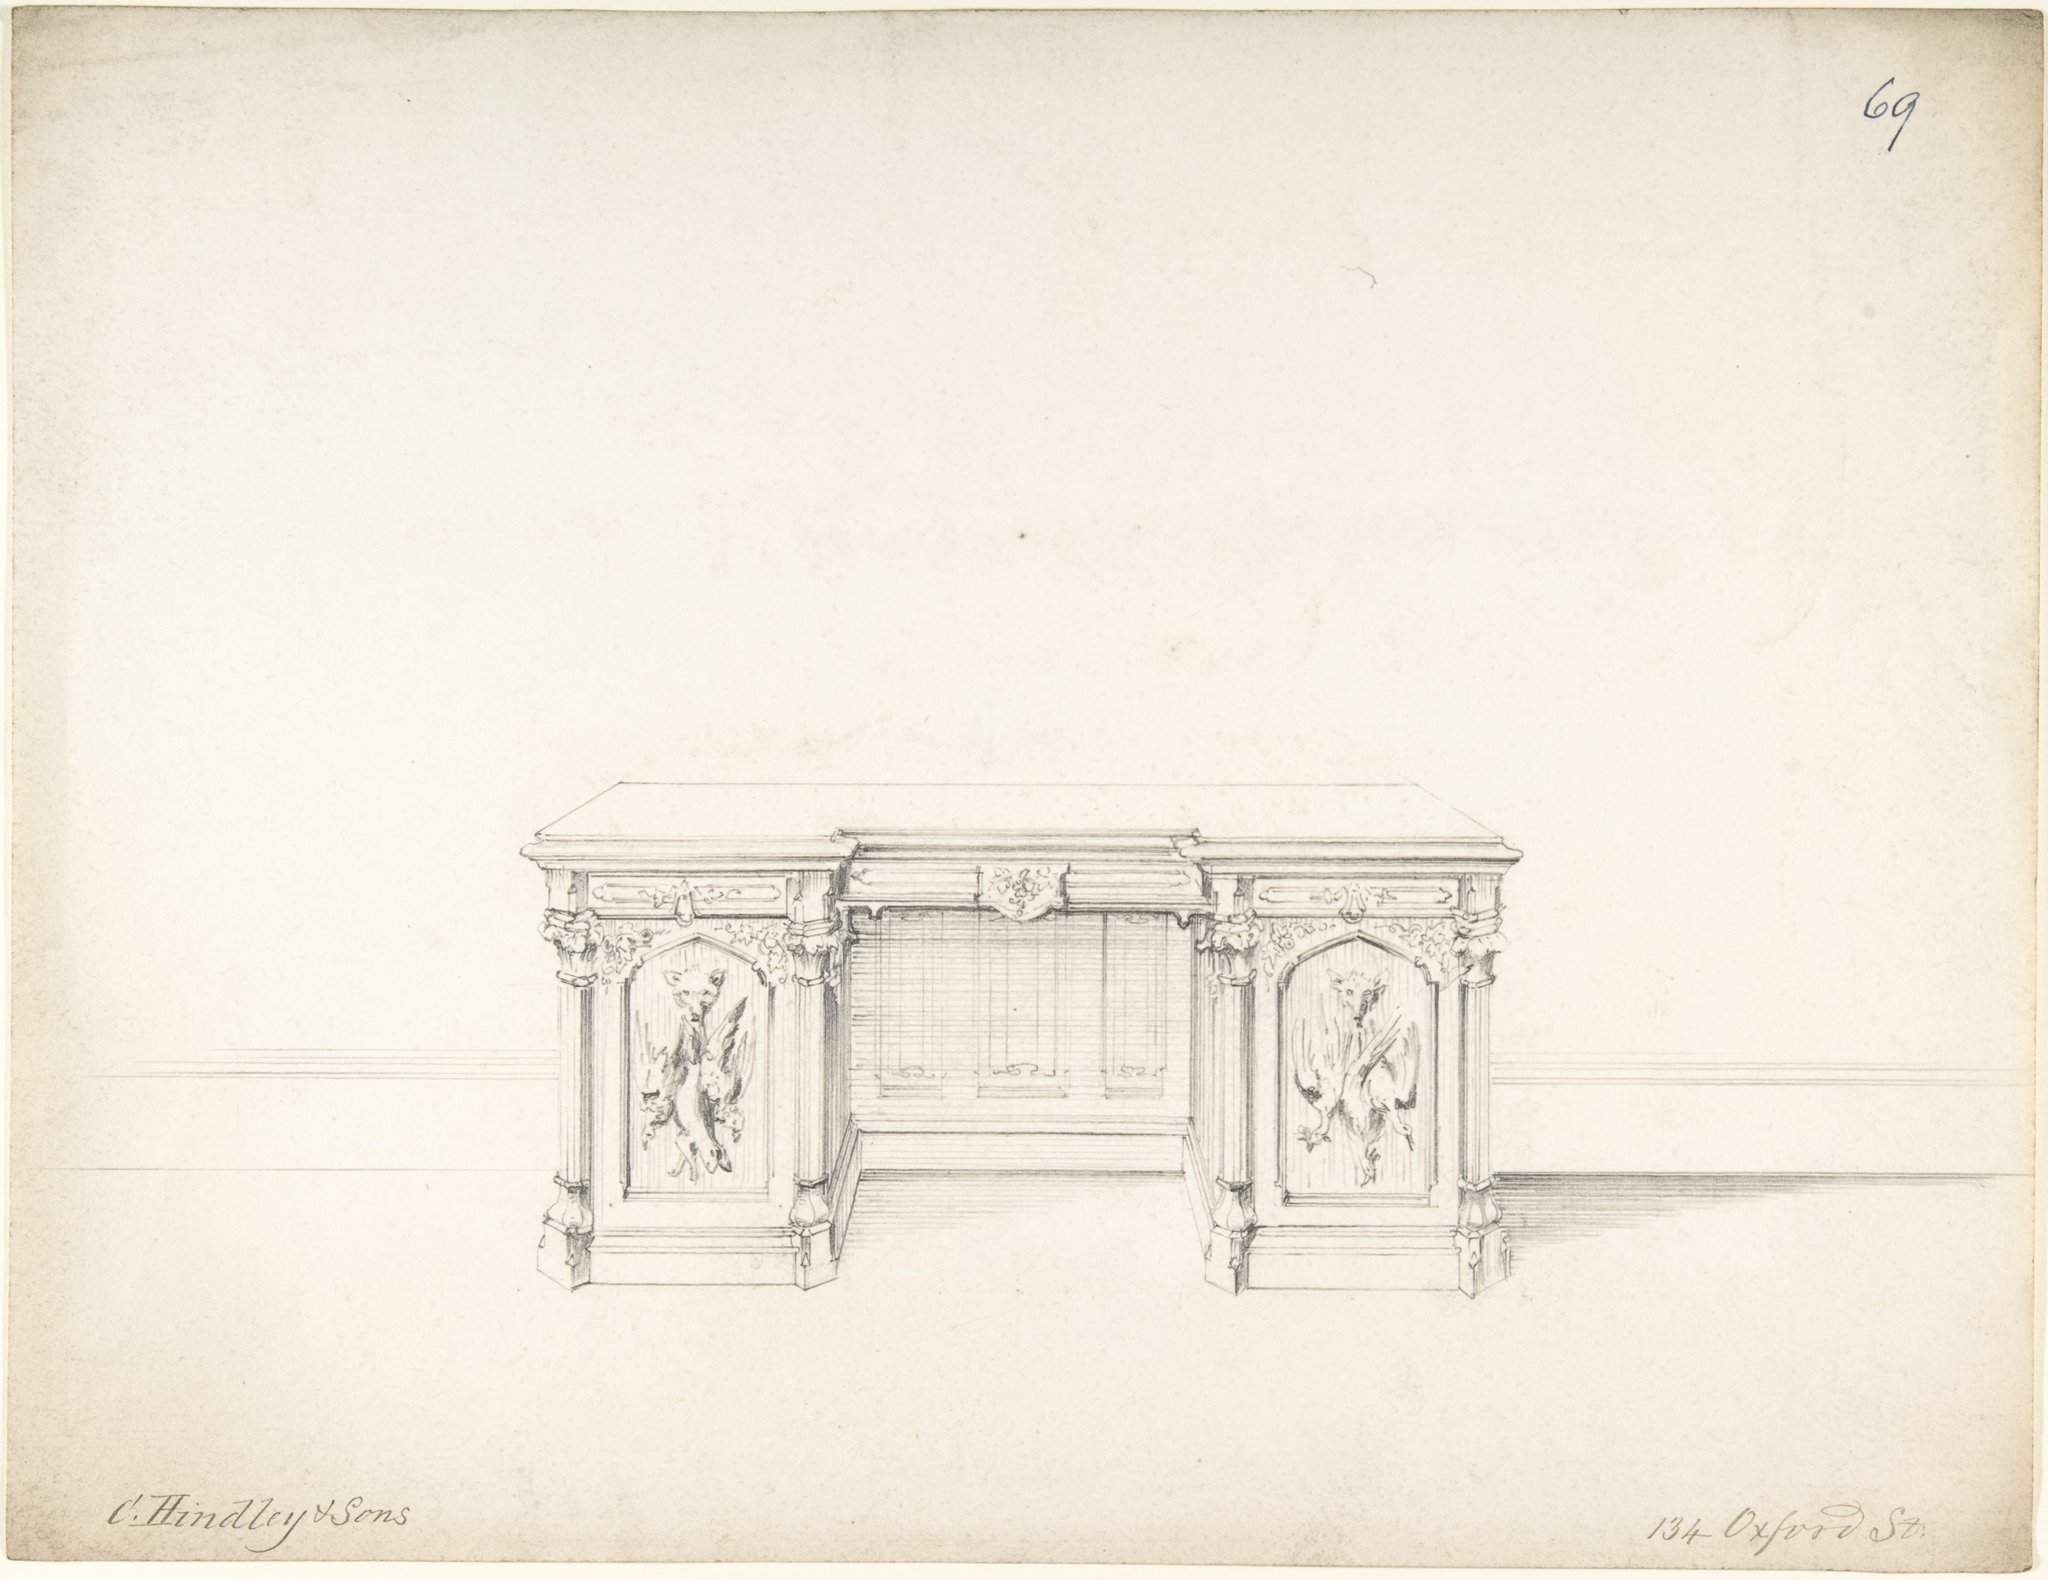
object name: drawing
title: Design for Wooden Desk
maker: charles hindley and sons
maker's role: artist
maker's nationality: british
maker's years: 1841-1917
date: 1841-1884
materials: graphite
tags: desks